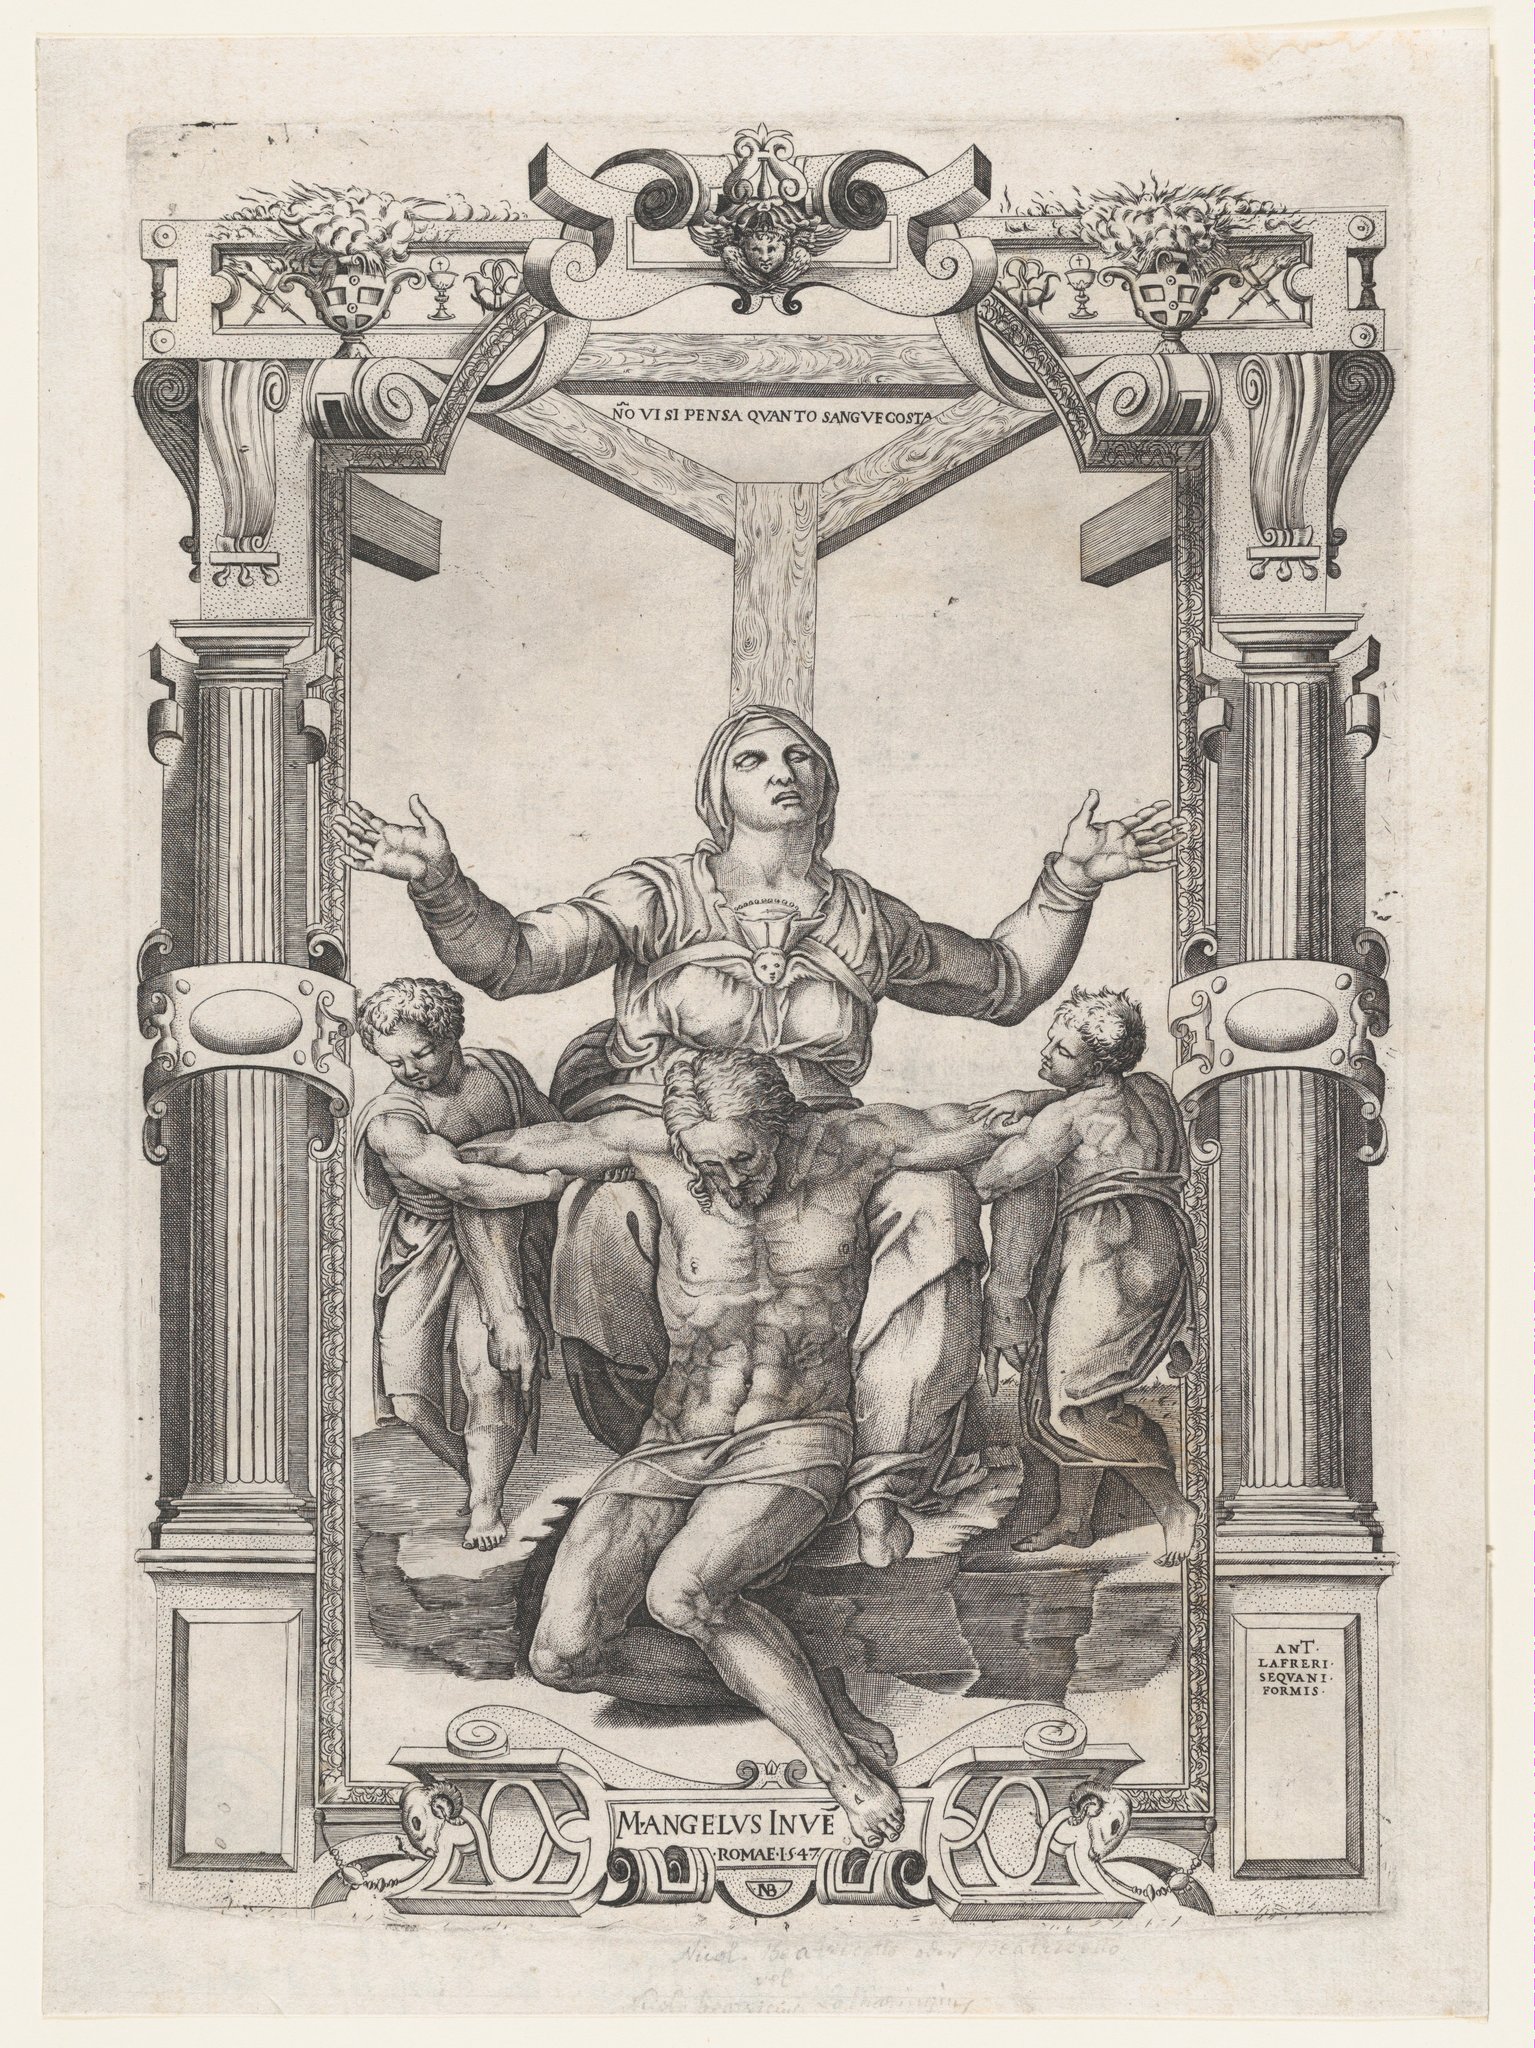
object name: print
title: Pietà with Angels in Front of the Cross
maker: nicolas beatrizet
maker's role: engraver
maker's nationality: french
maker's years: 1515-1566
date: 1547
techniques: engraving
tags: men,women,christ,virgin mary